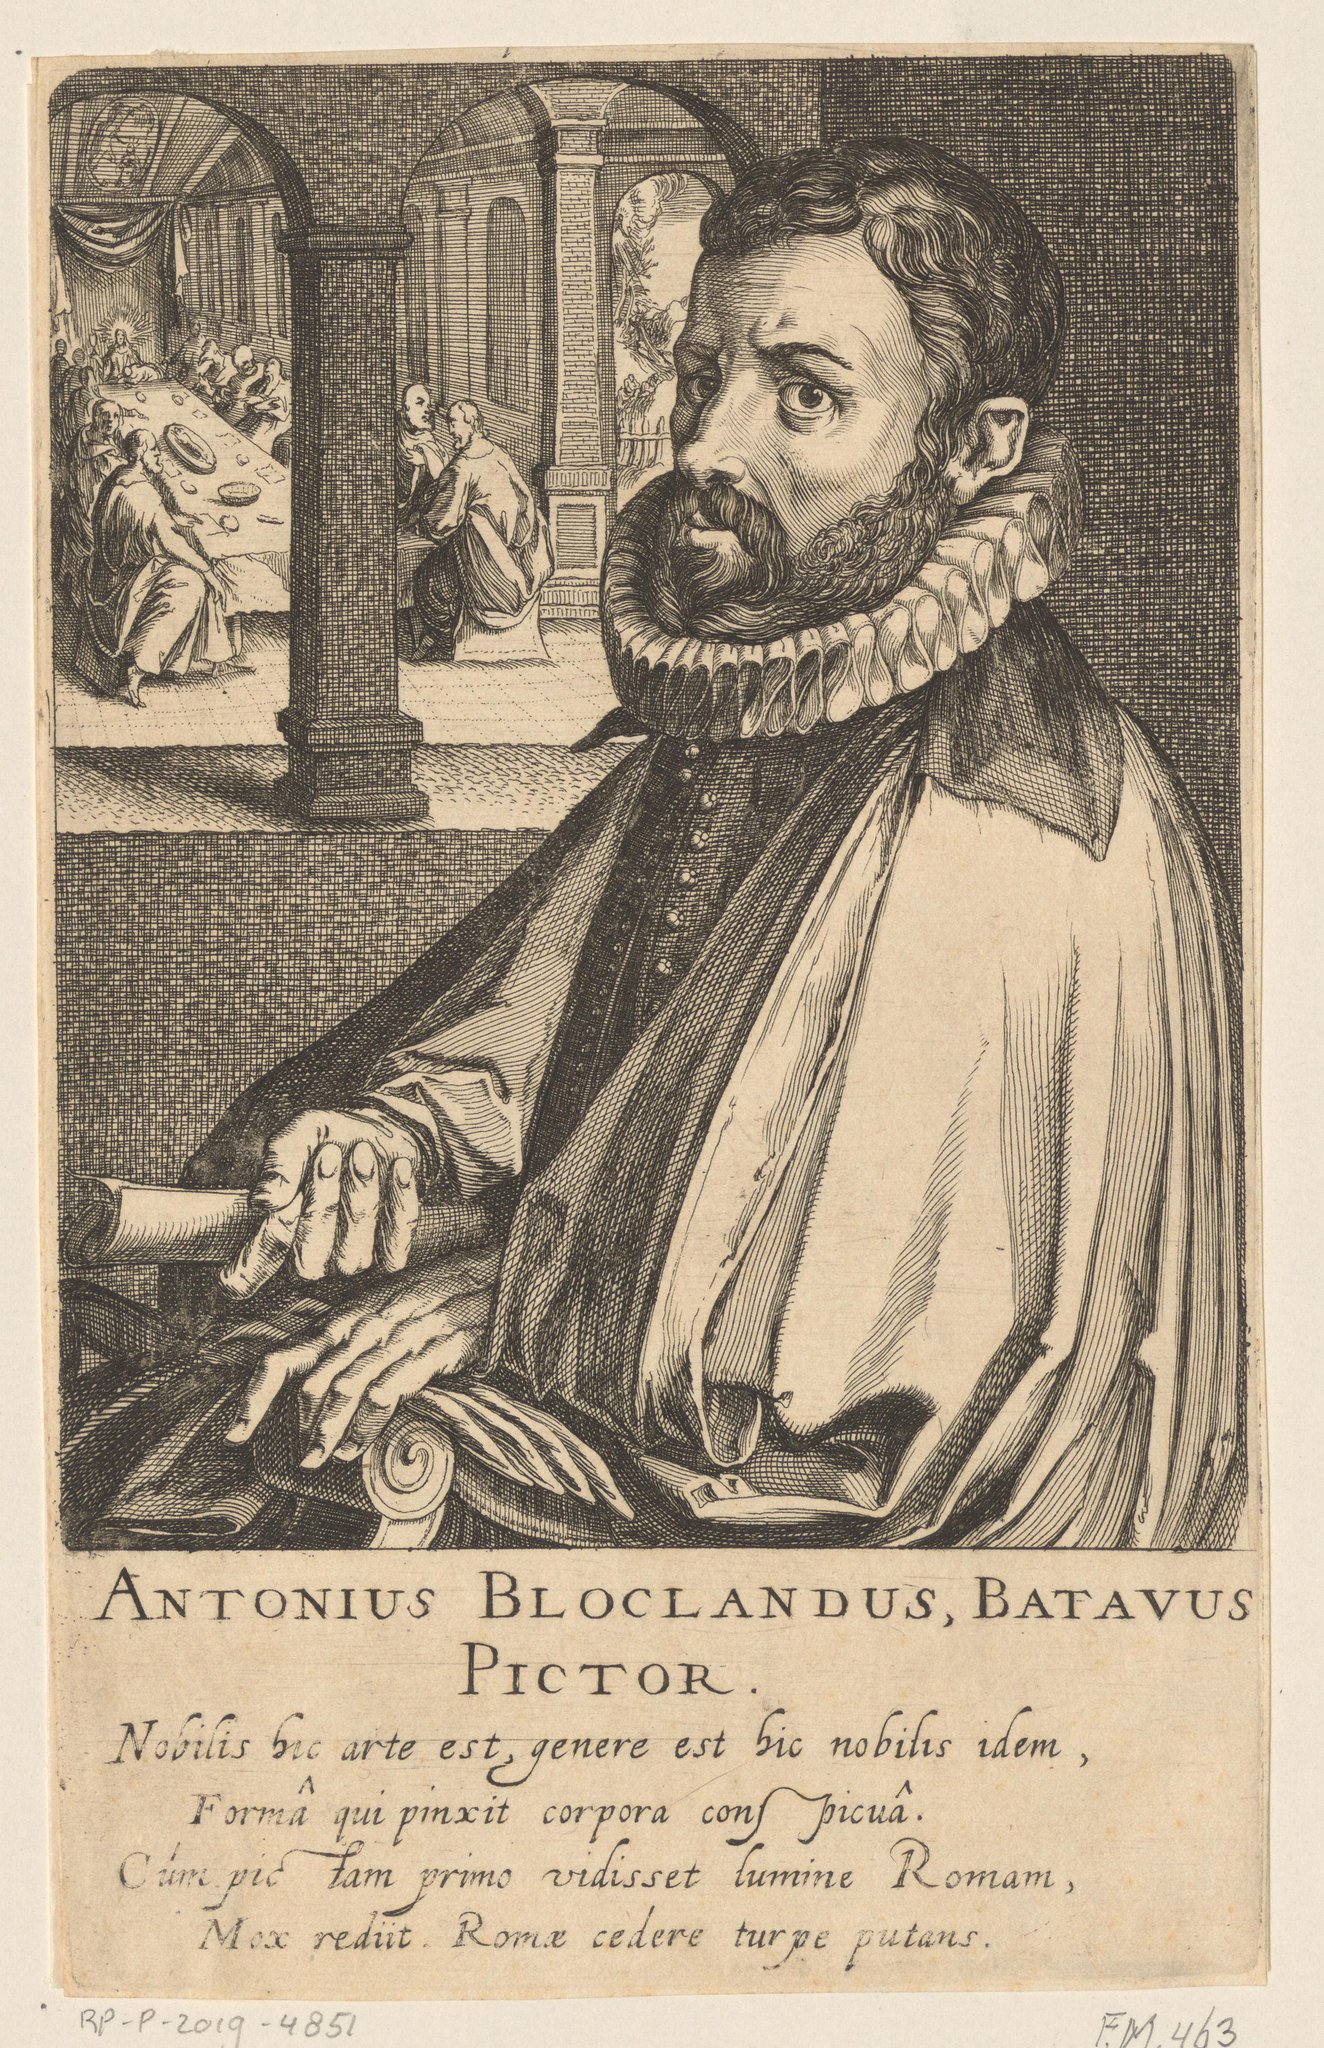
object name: print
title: Pictorum aliquot celebrium praecipuae Germaniae Inferioris effigies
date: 1610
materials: paper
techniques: engraving, etching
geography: the hague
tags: utrecht, draughtsman, anthonie blocklandt, historical persons, portrait, self-portrait of painter, last supper (in general) (matthew 26:21-35; mark 14:18-31; luke 22:3, 22:15-23; john 13:21-38)